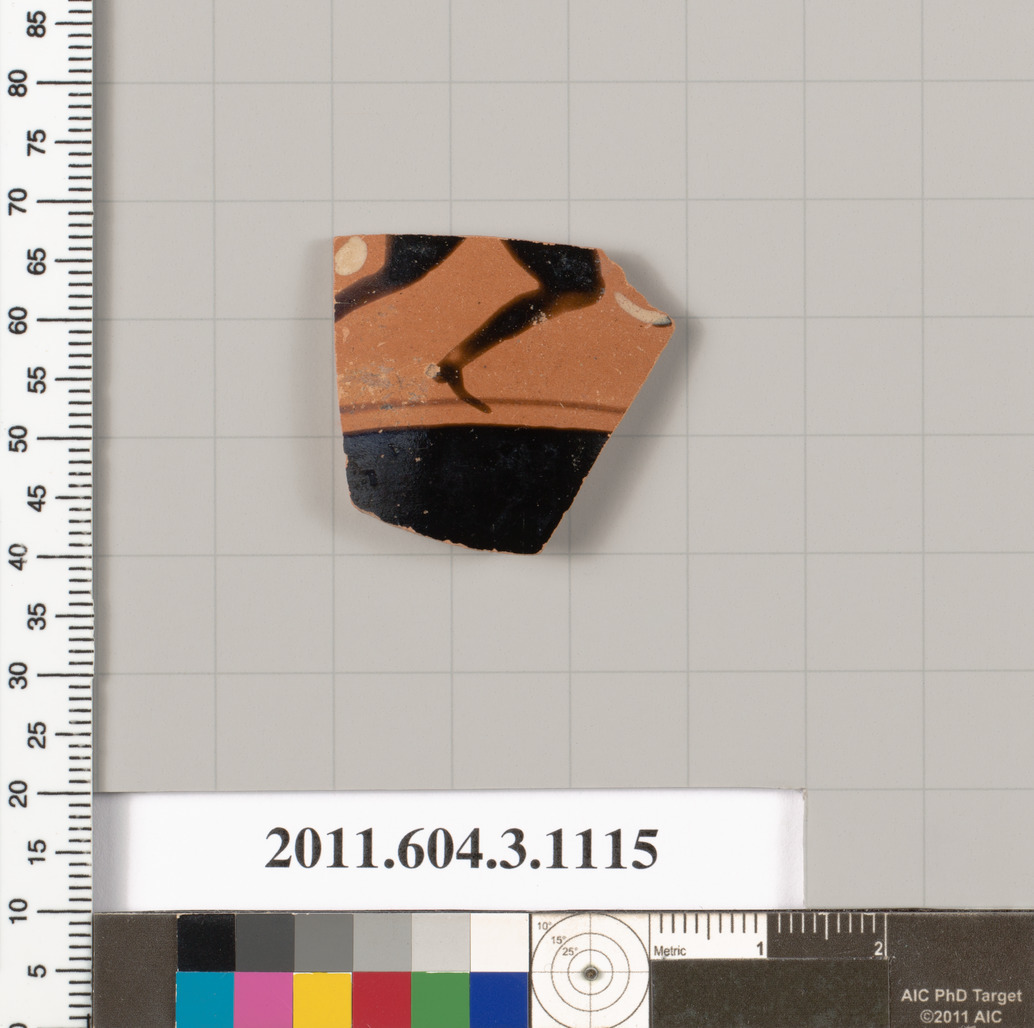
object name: mastoid or kyathos fragment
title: Terracotta fragment of a mastoid (drinking cup with narrow base) or a kyathos (cup-shaped ladle)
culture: greek, attic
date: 534-468 BCE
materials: terracotta